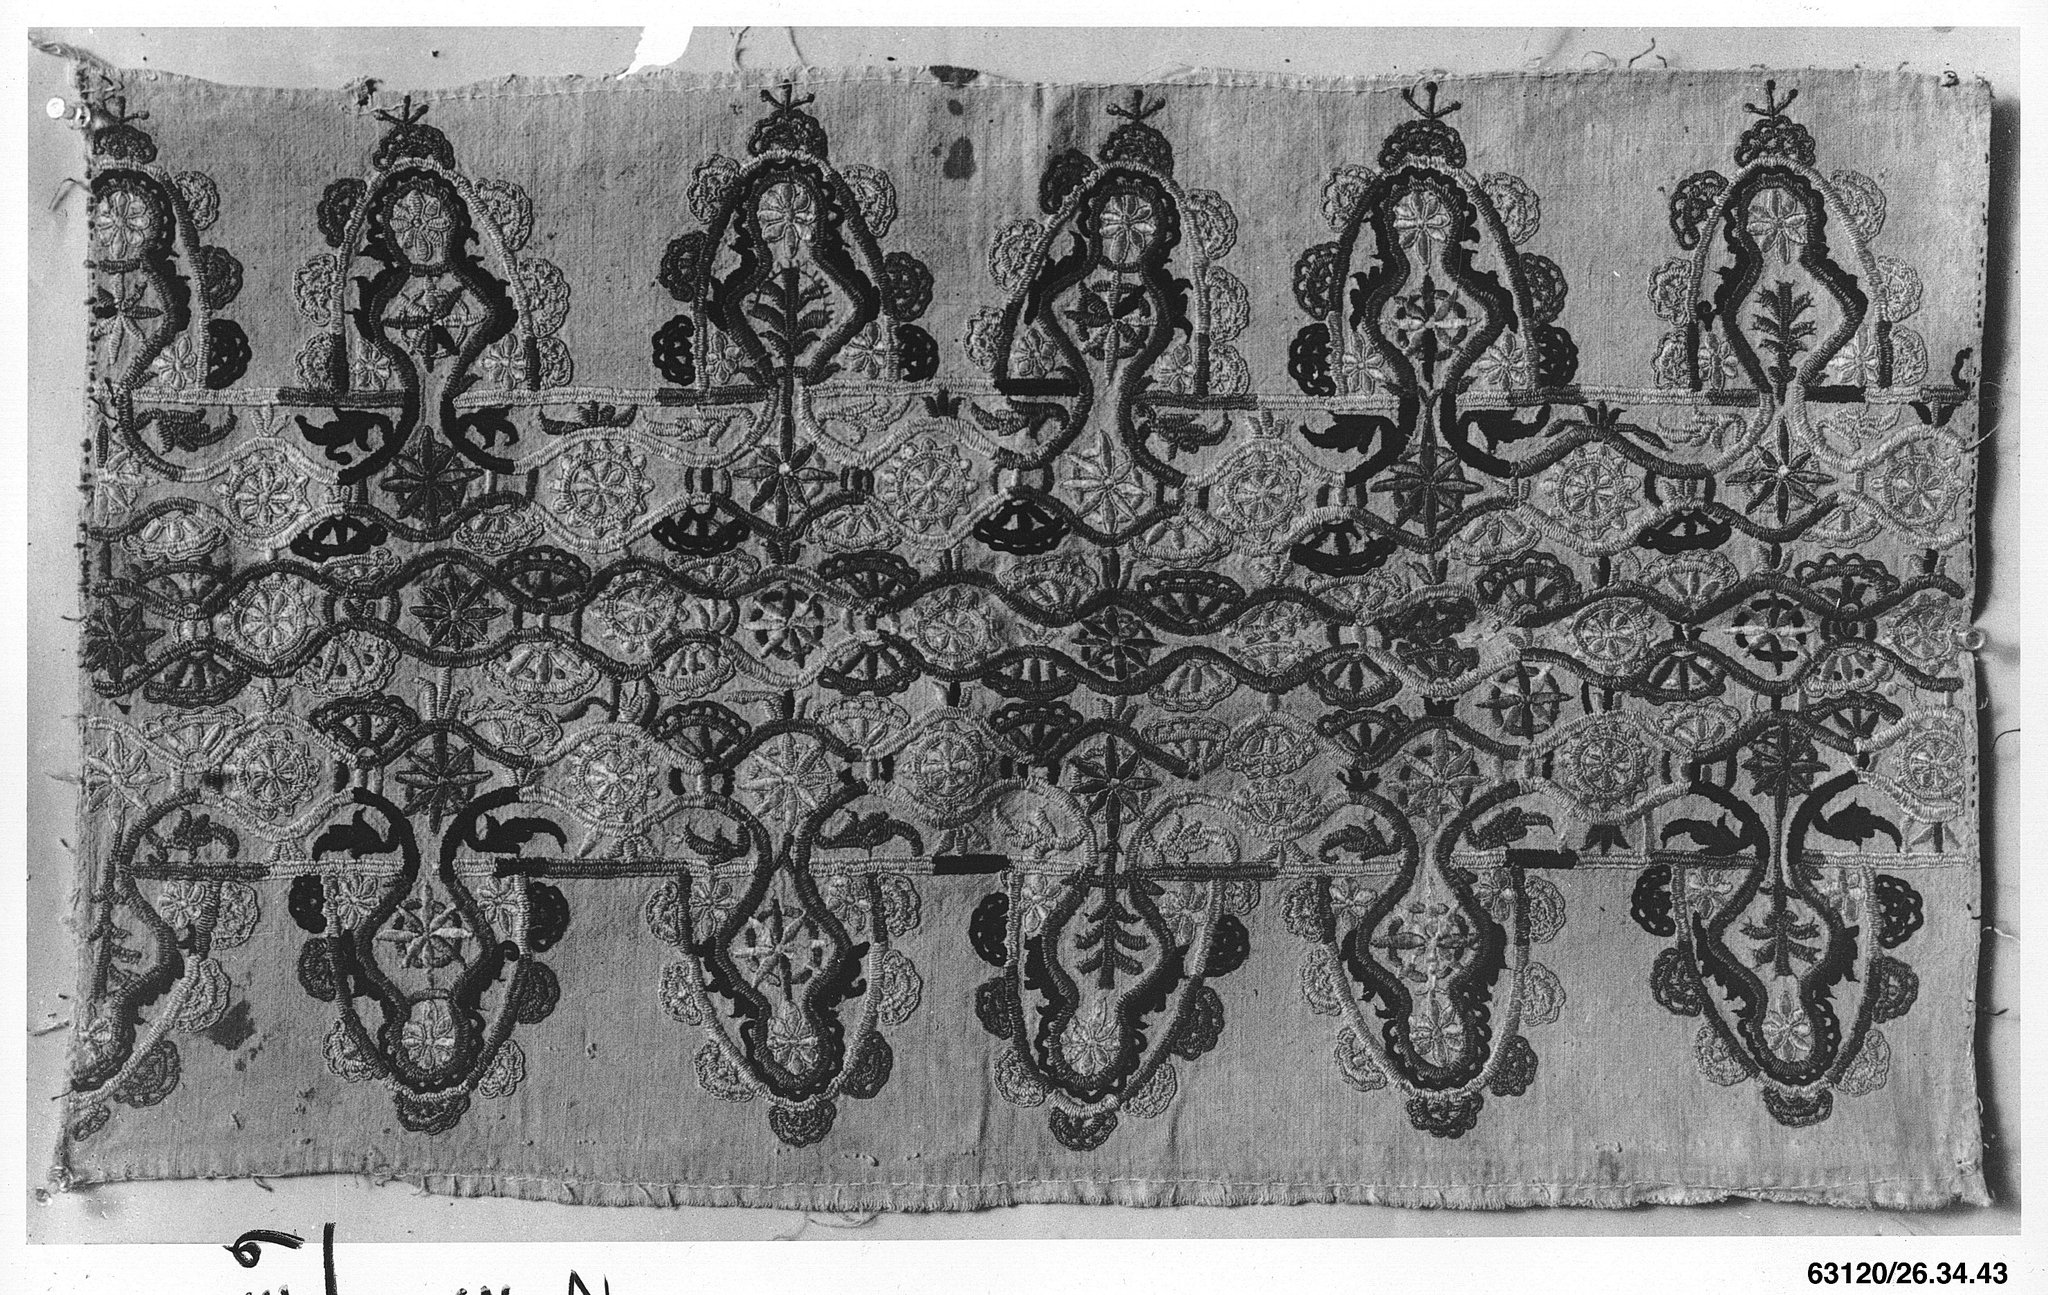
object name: border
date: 1701-1800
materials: linen, silk